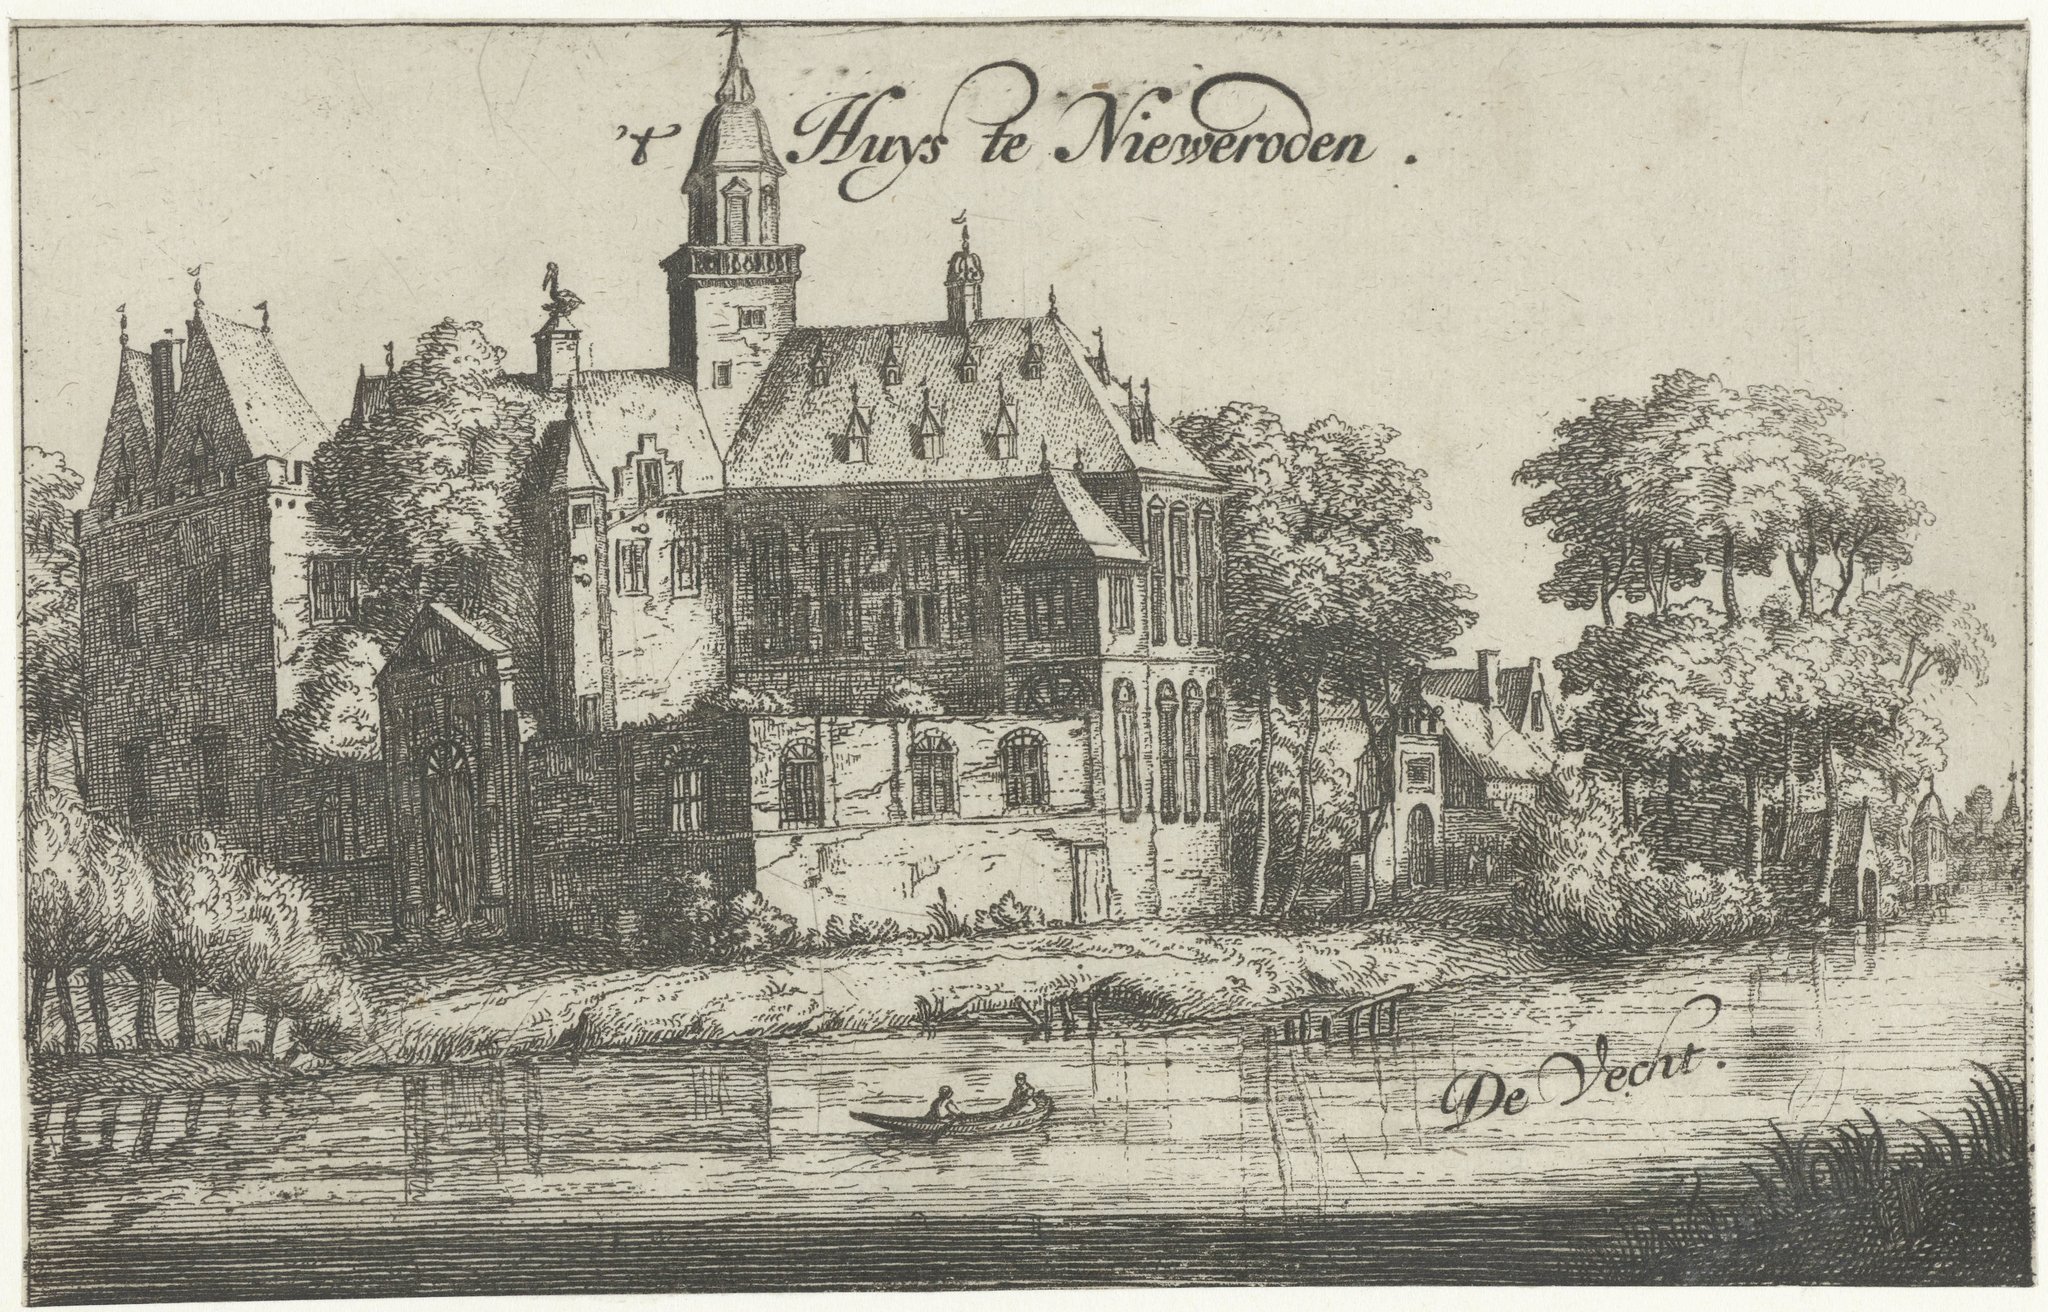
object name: print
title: Kasteel Nijenrode aan de Vecht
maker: johannes leupenius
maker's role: draughtsman, painter, print maker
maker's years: 1646-1693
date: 1666-1693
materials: paper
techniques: etching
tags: castle, river, vecht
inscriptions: collector's mark: Lugt 2165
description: Gezicht op kasteel Nijenrode aan de Vecht te Breukelen. De prent maakt deel uit van een zesdelige serie met voorstellingen van aan de Vecht en Amstel gelegen kastelen en herbergen.